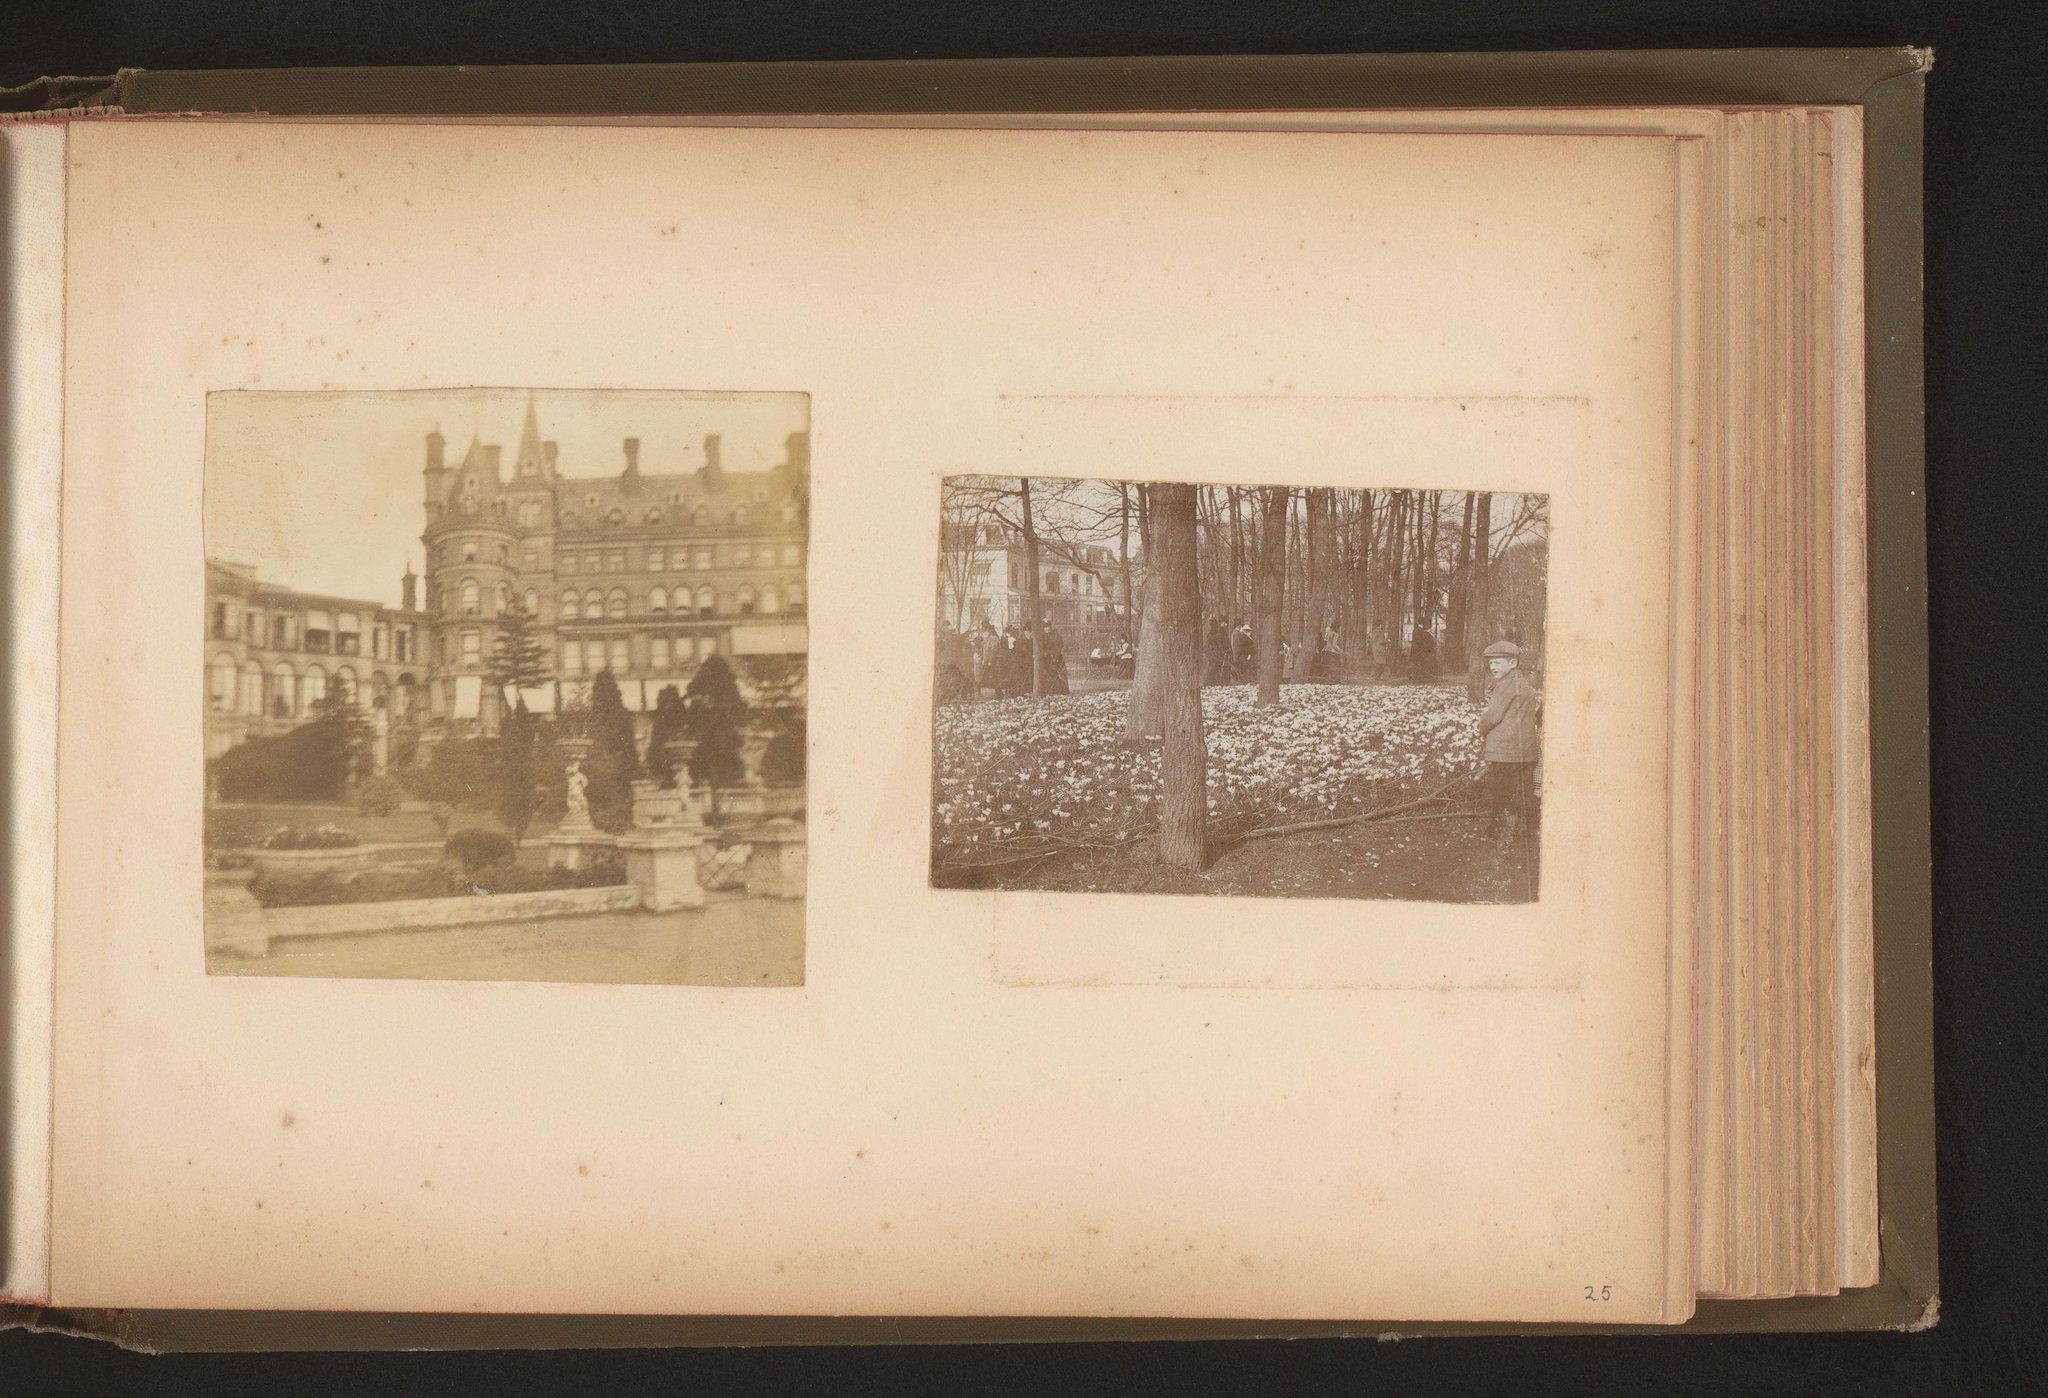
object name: photograph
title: Twee foto's van verschillende stadsparken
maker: Anonymous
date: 1895-1910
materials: paper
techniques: albumen print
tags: public gardens, park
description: Deze foto's maken deel uit van een album.